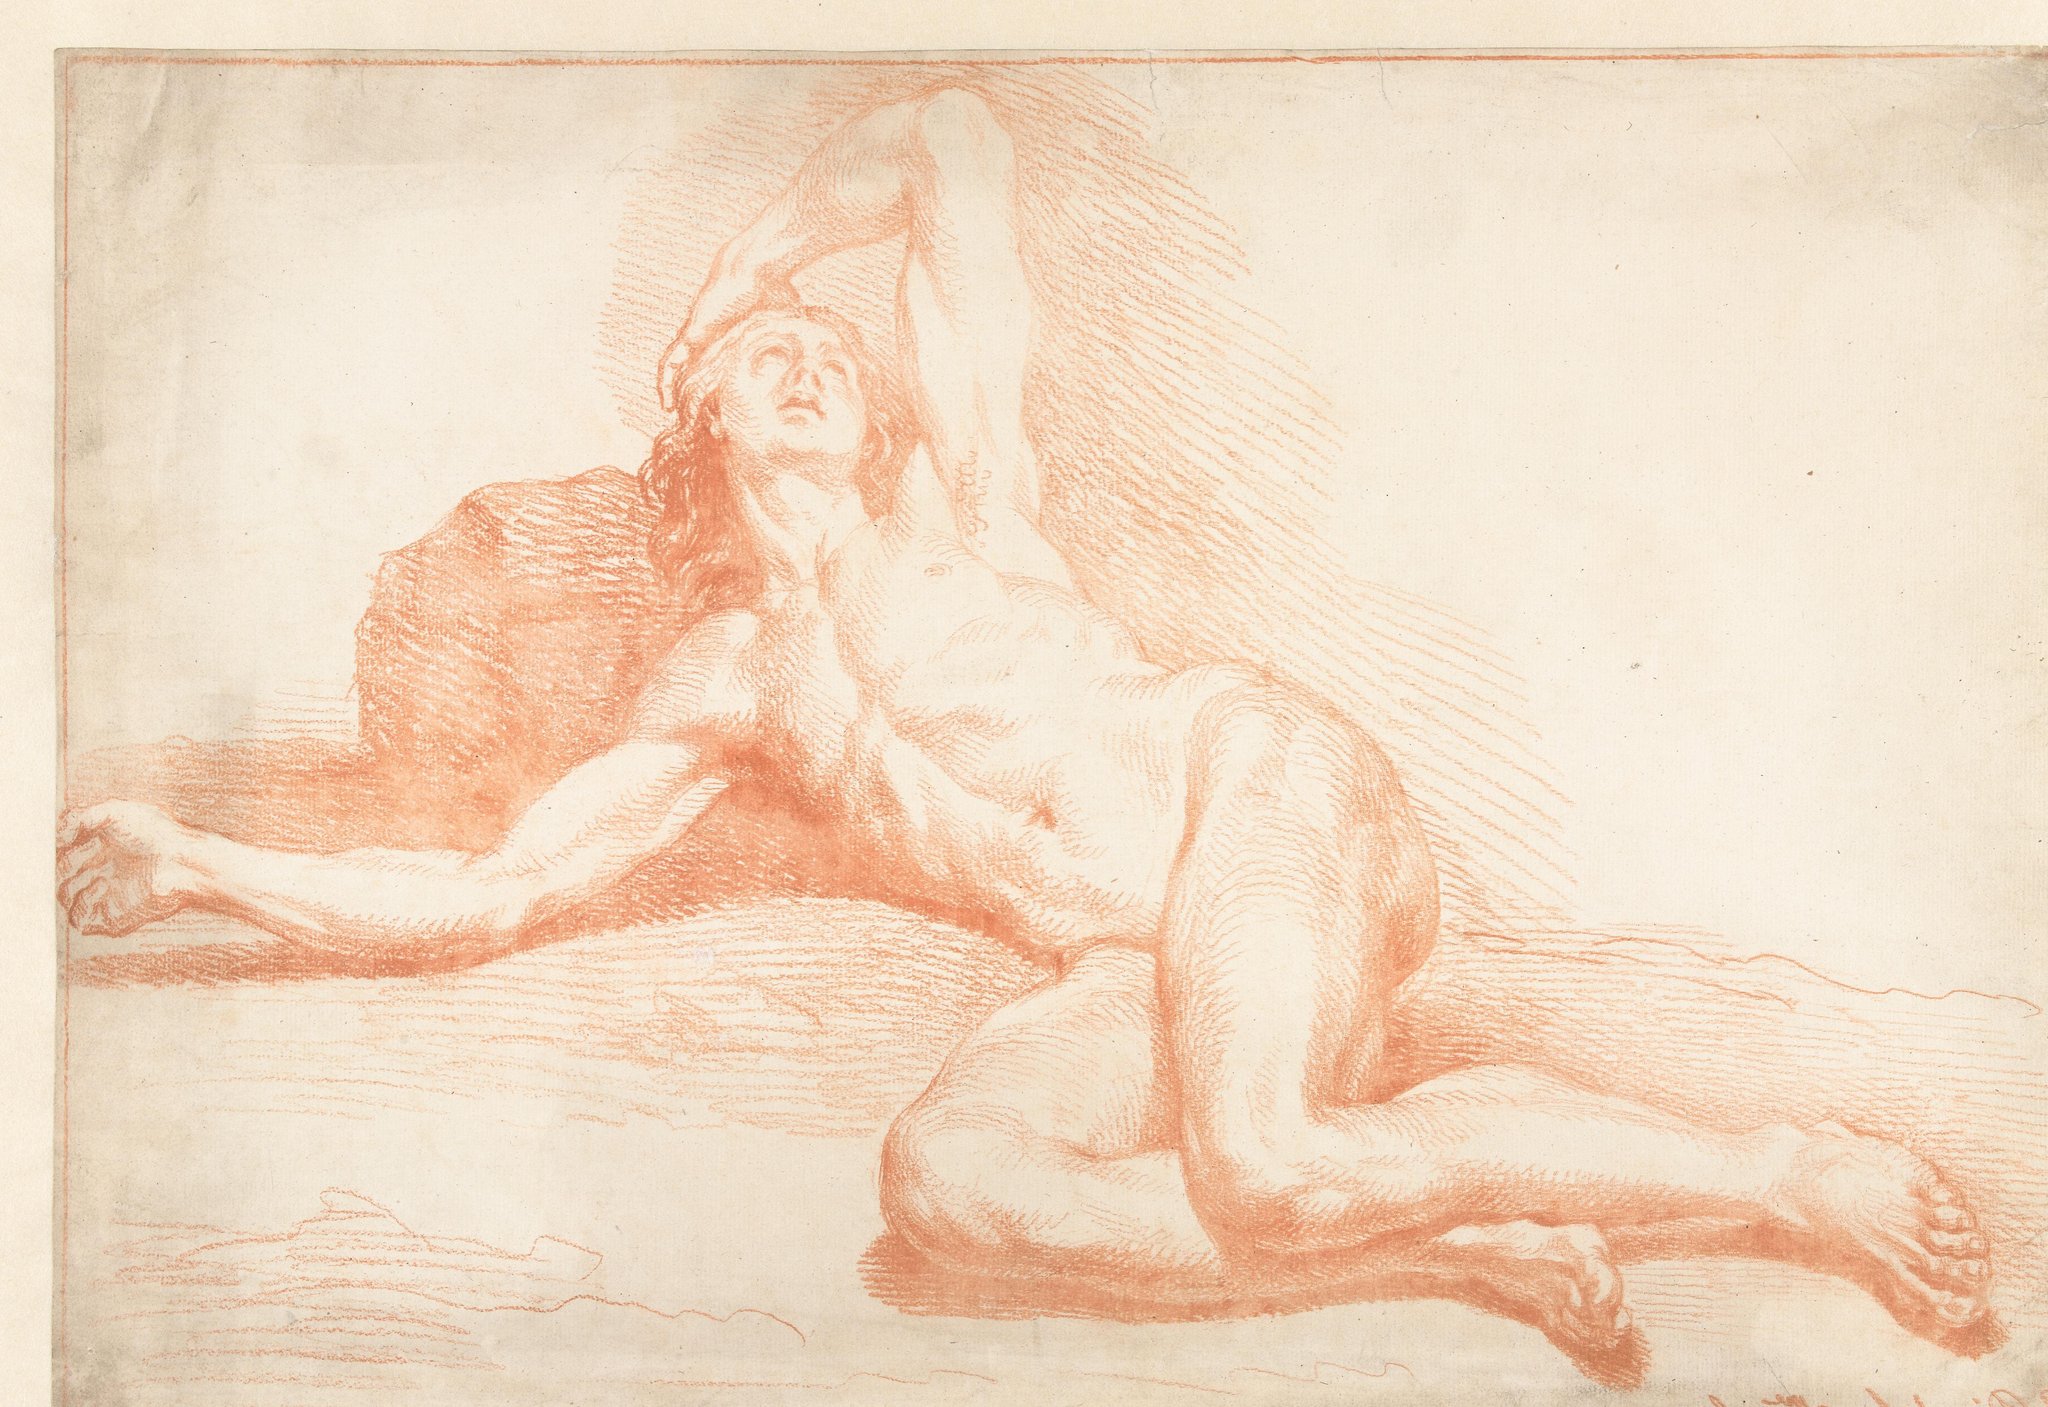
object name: drawing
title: Liggend naakt, het hoofd bij een steen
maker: bernard picart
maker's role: draughtsman, print maker, publisher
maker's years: 1673-1733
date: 1723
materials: chalk, paper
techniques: printmaking